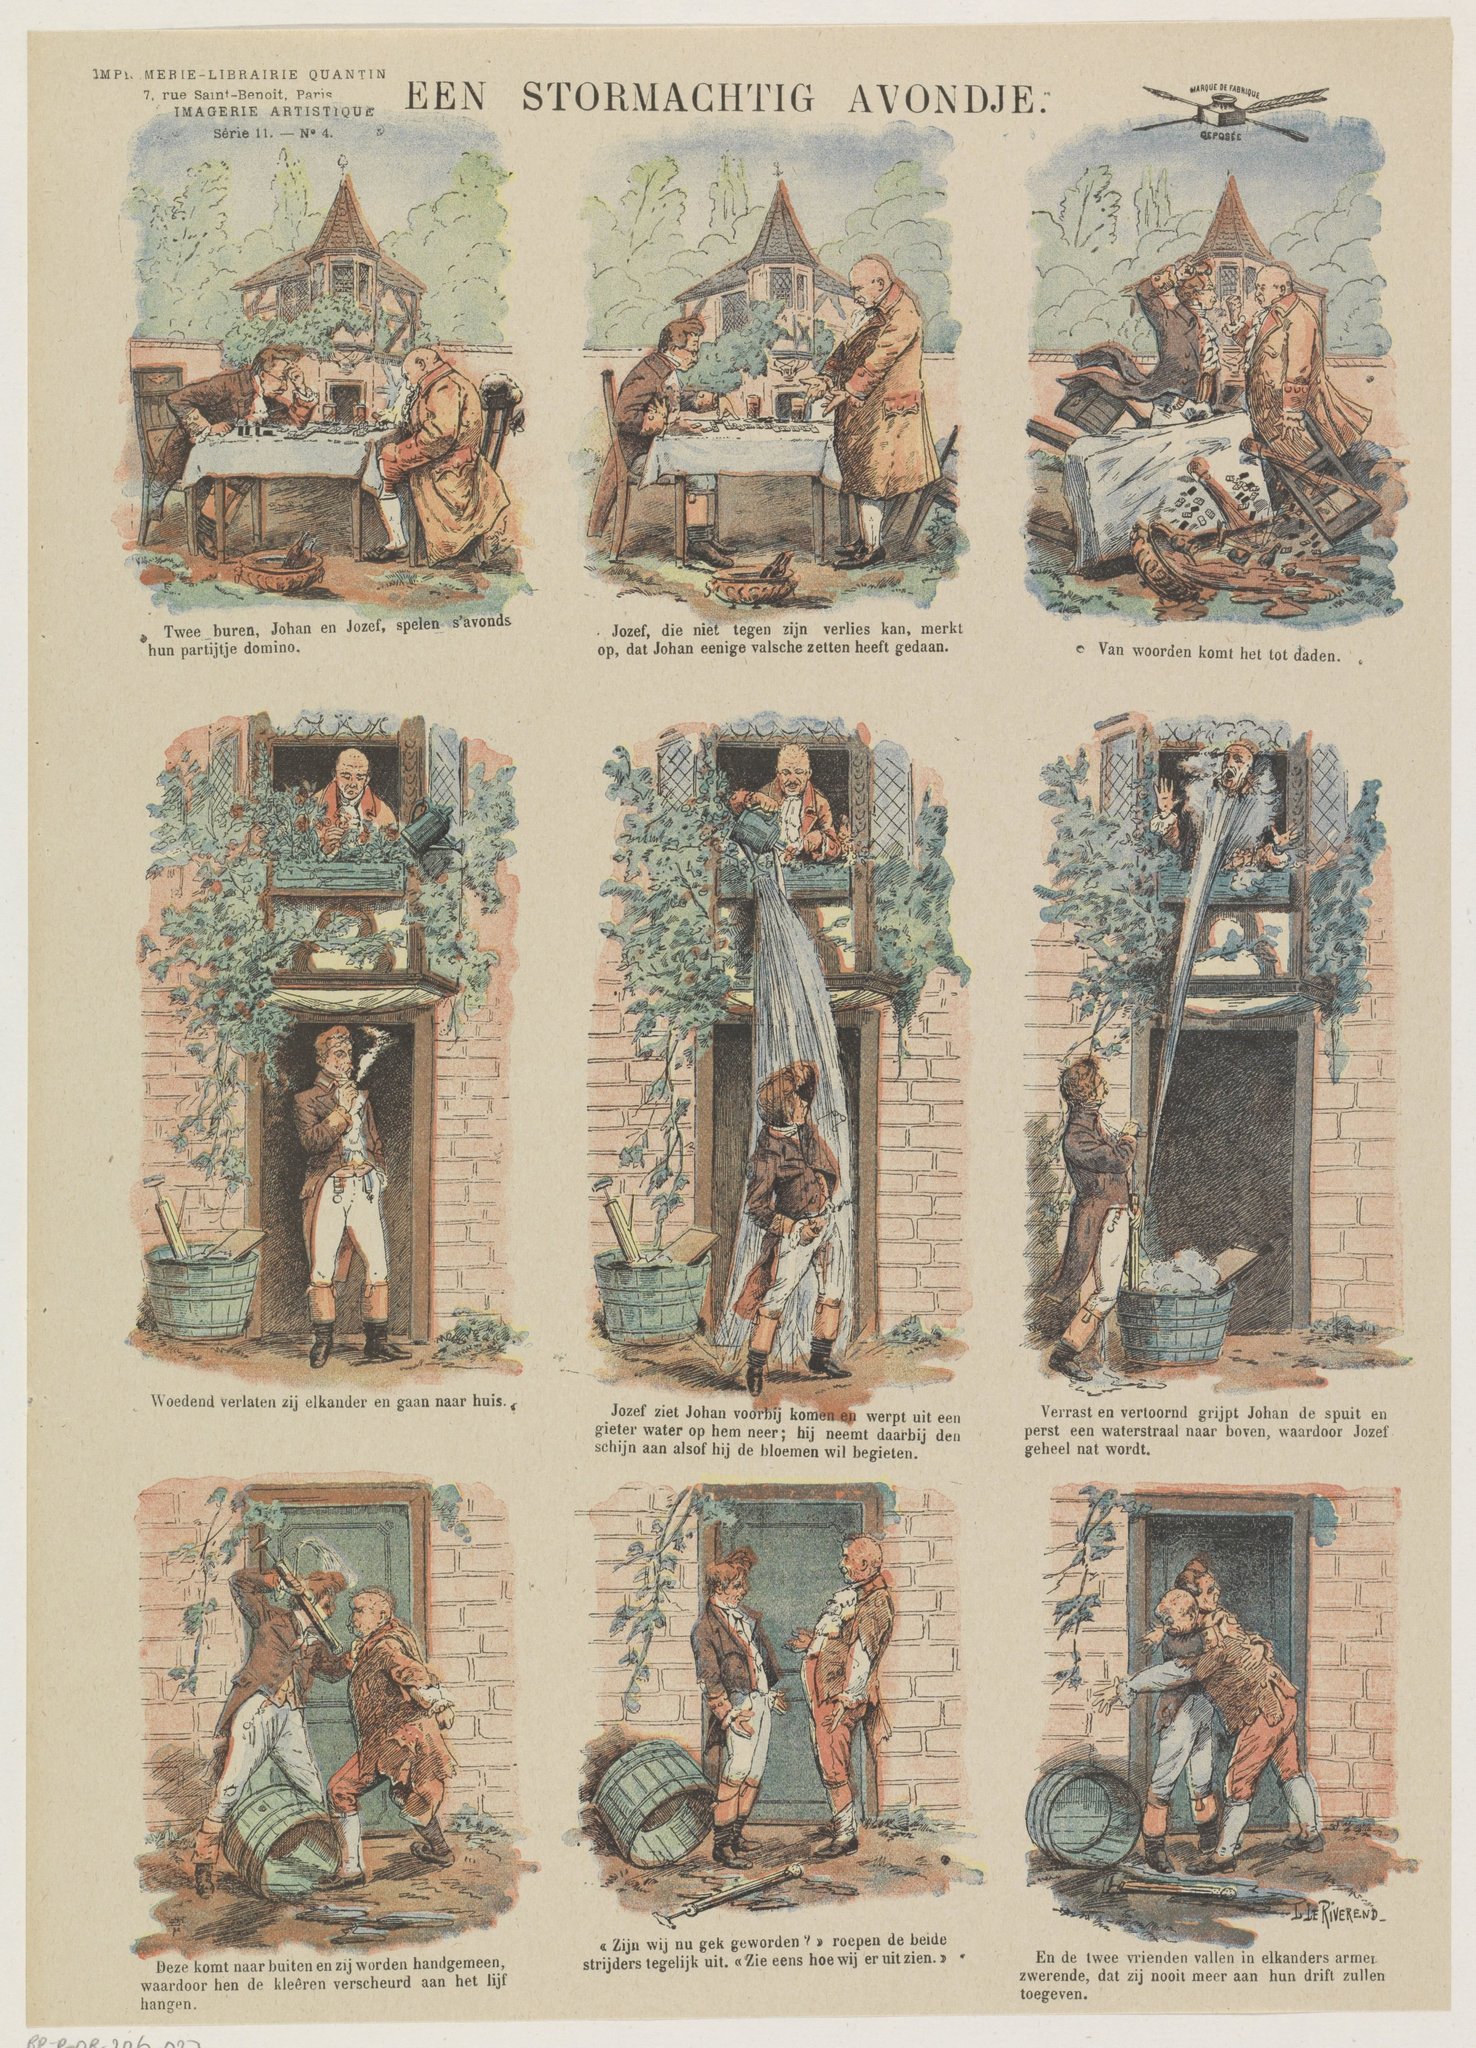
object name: popular print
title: Imagerie Artistique / Série 11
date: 1876-1890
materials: paper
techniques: lithograph, letterpress printing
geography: paris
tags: neighbour, tales and fairy tales, fighting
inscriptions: : ‘marque de fabrique / deposée’, collector's mark: Lugt 2760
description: Blad met 9 voorstellingen van twee buren die ruziemaken. Onder elke afbeelding een onderschrift. Genummerd linksboven: Série 11. - No. 4.